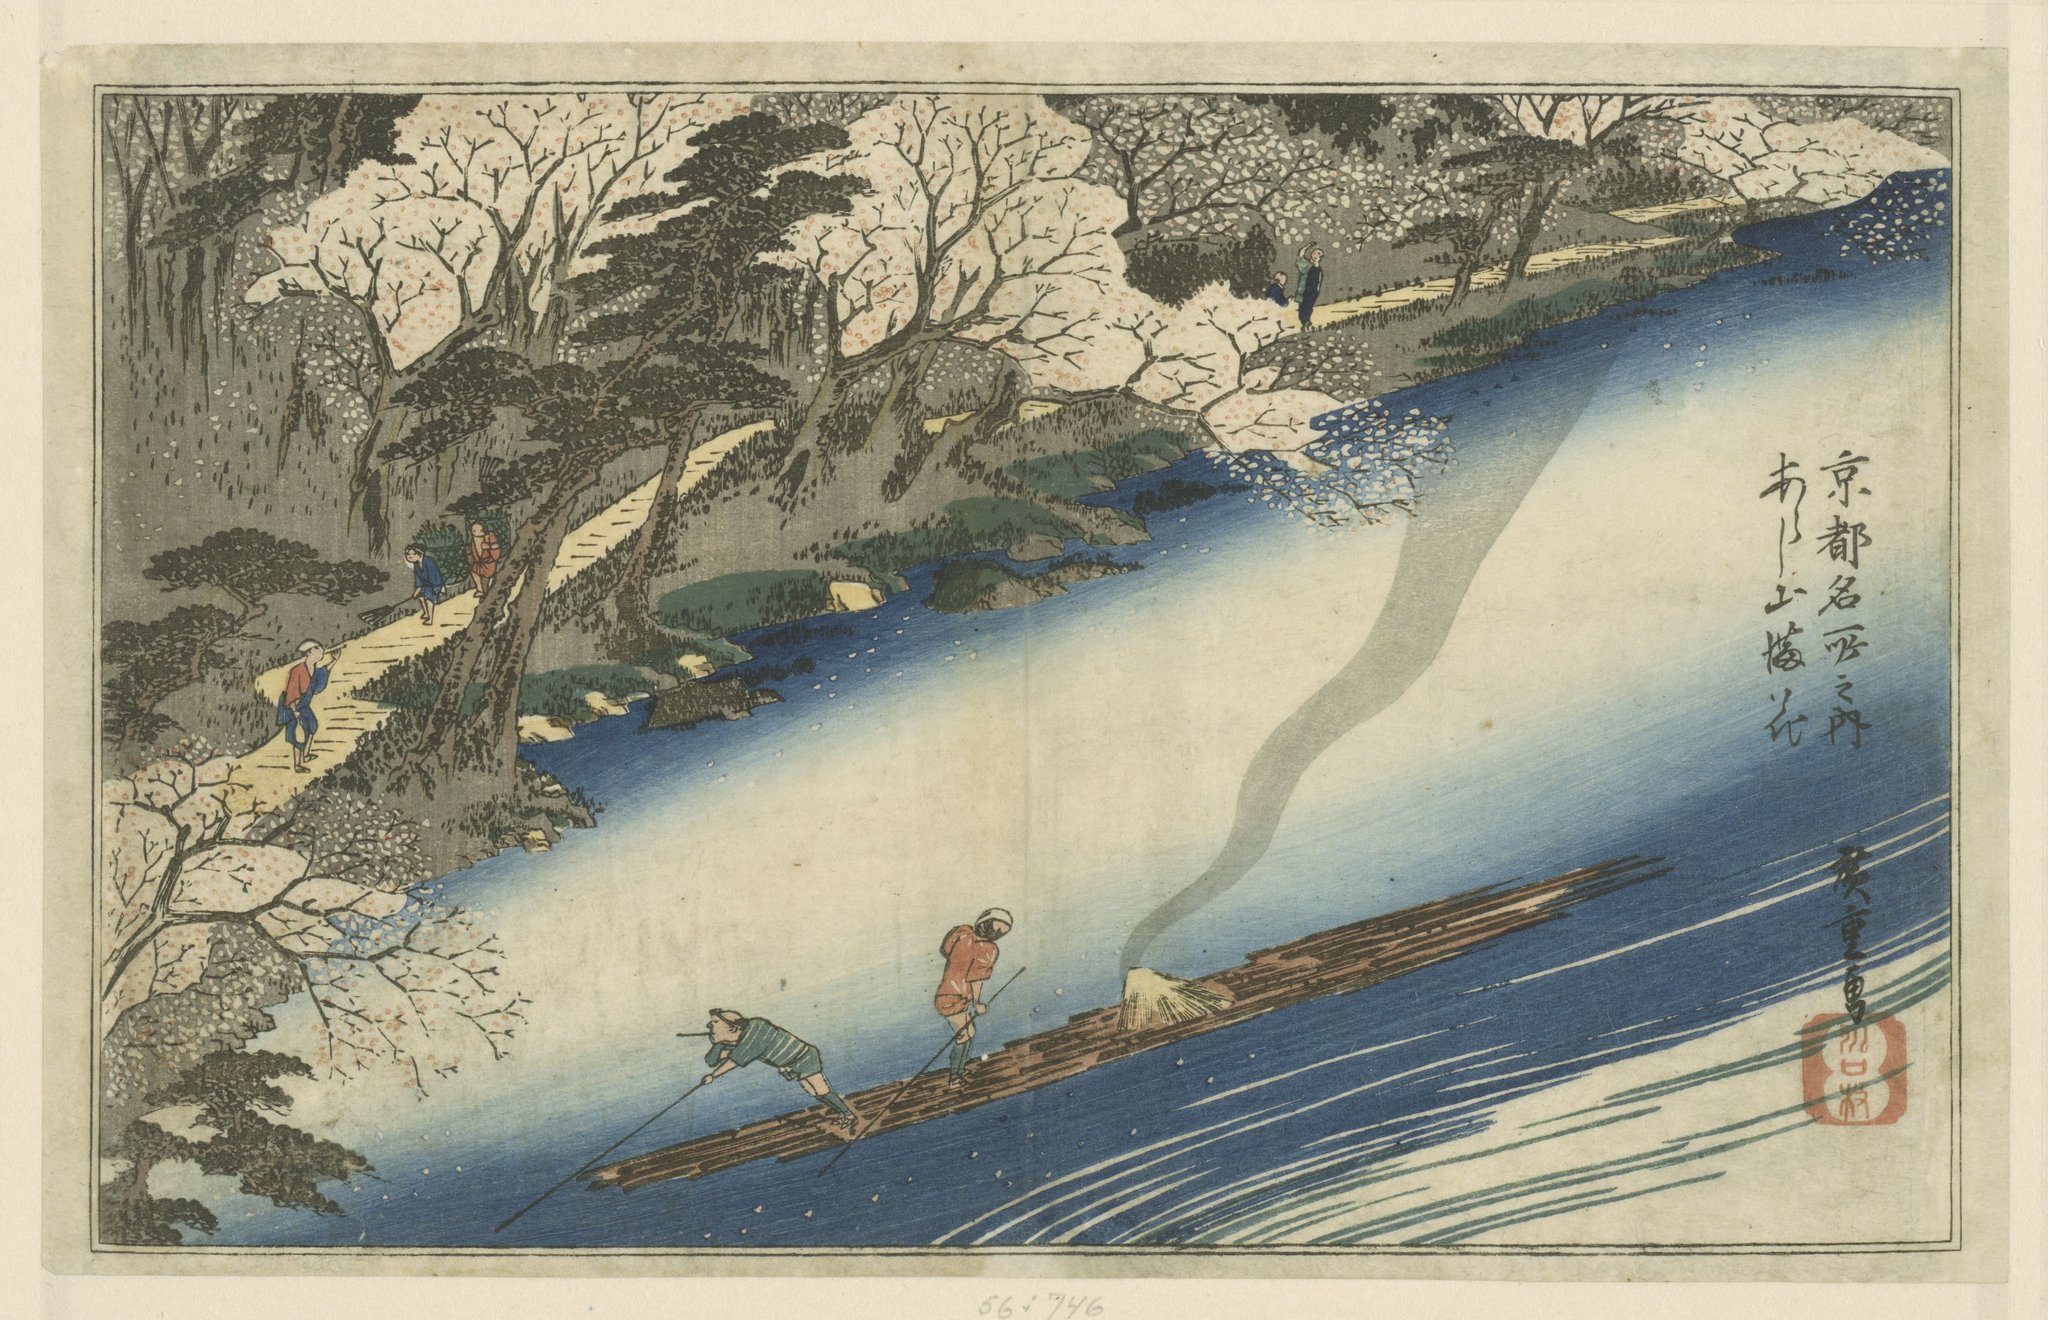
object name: print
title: Arashiyama manka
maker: utagawa hiroshige (i)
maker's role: draughtsman, print maker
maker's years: 1797-1858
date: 1833-1837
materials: paper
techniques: nishiki e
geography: japan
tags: river, rowing-boat, canoe, etc.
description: Een vlot met twee mannen op de Hozu rivier in Arashiyama; op de oever wandelaars die de kersenbloesem bewonderen.